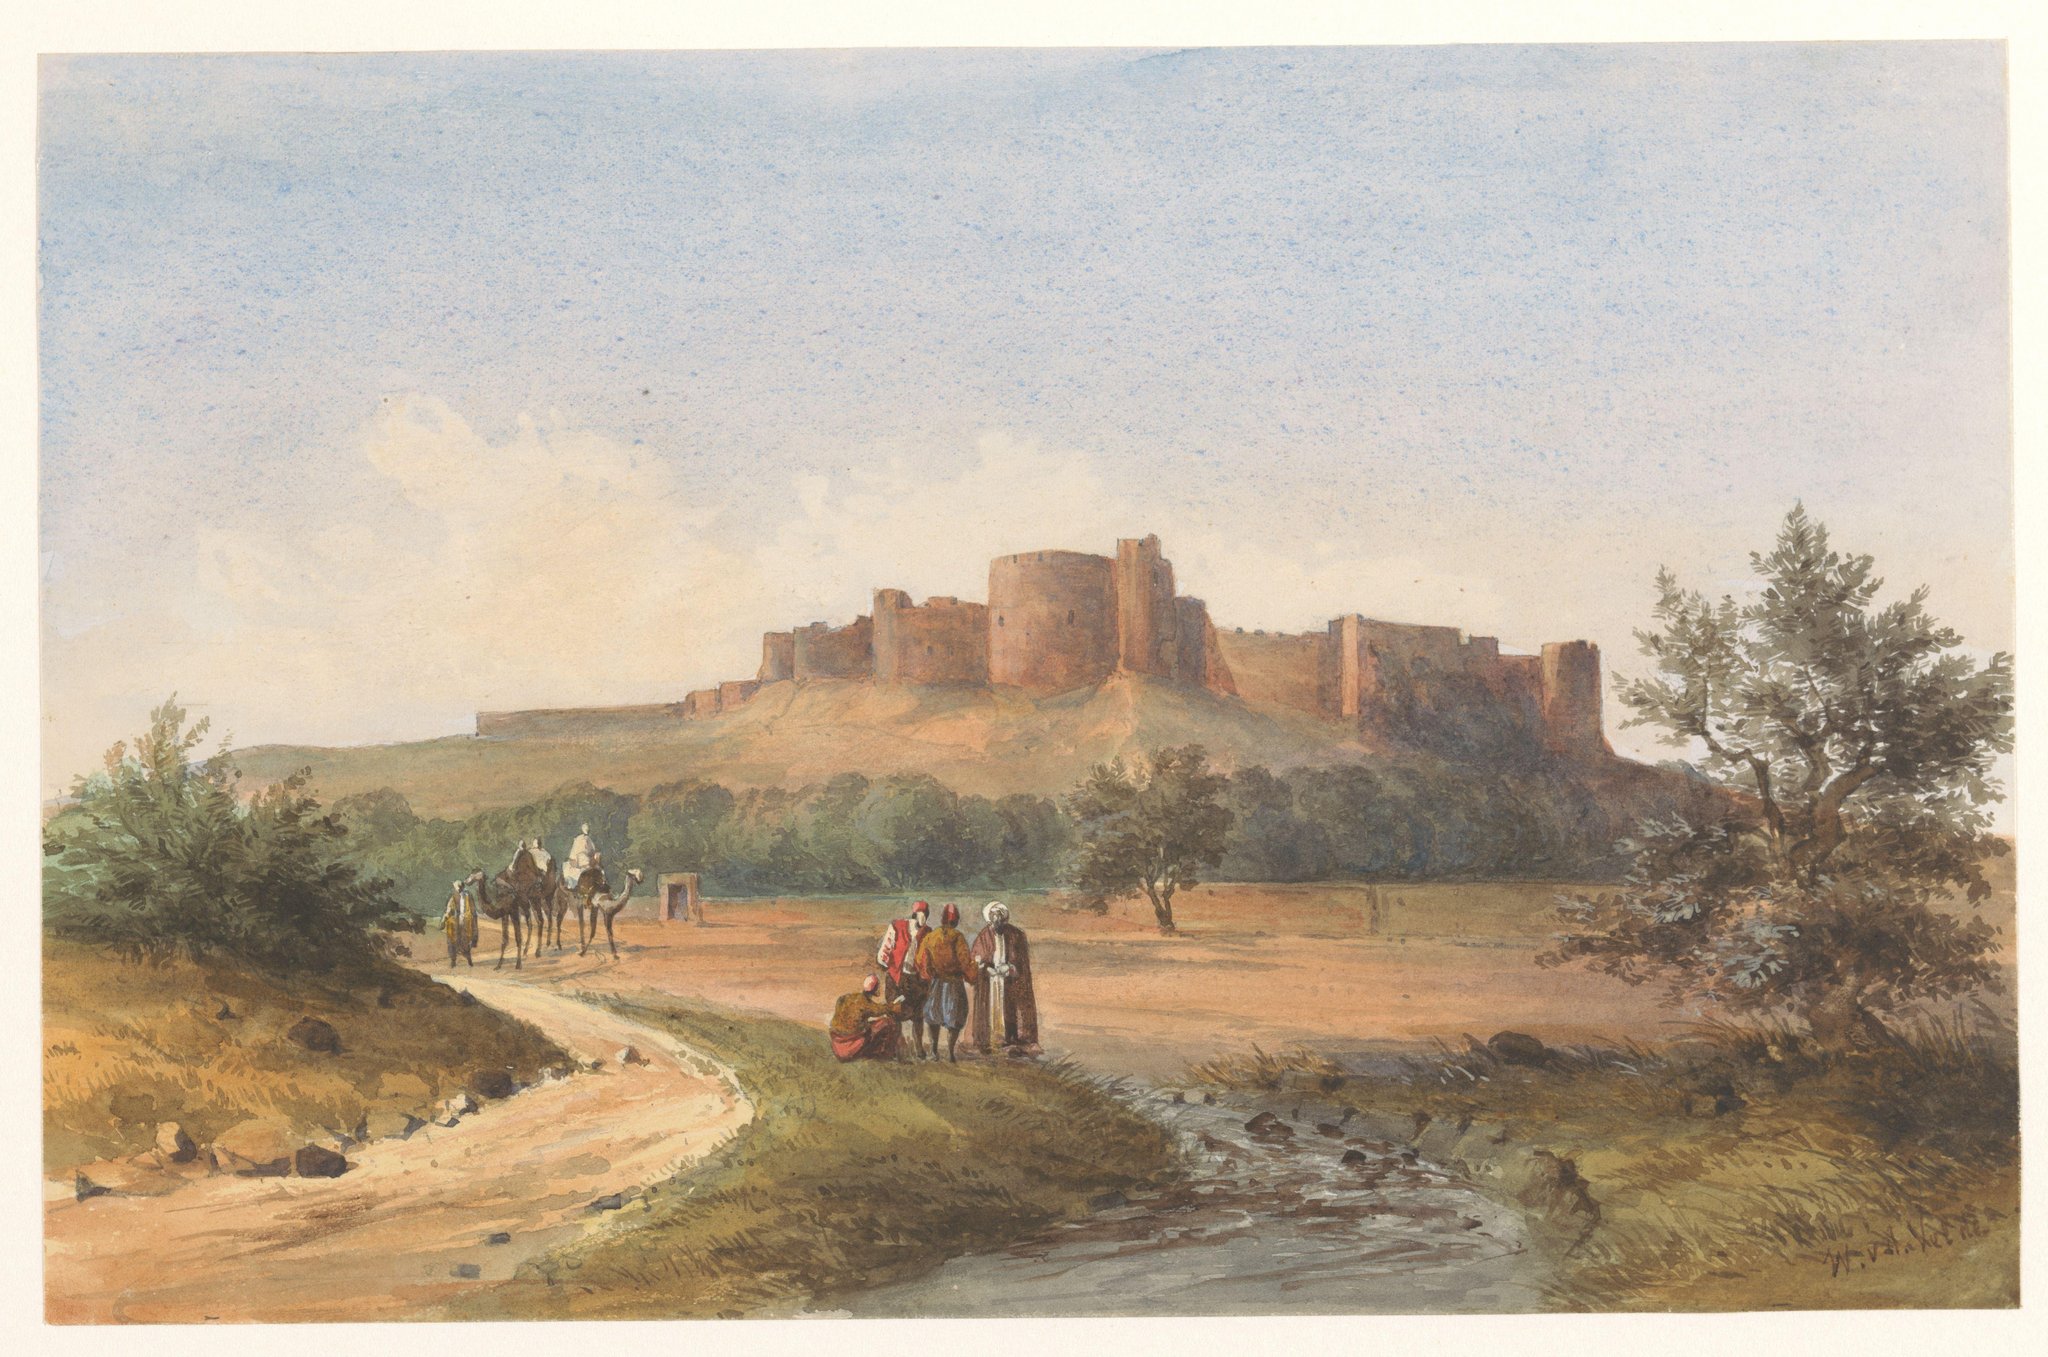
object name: drawing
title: Gezicht op het kasteel St. Louis te Sidon, Libanon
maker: charles william meredith van de velde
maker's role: draughtsman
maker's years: 1818-1898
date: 1828-1892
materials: chalk, paper, watercolor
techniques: brush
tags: castle